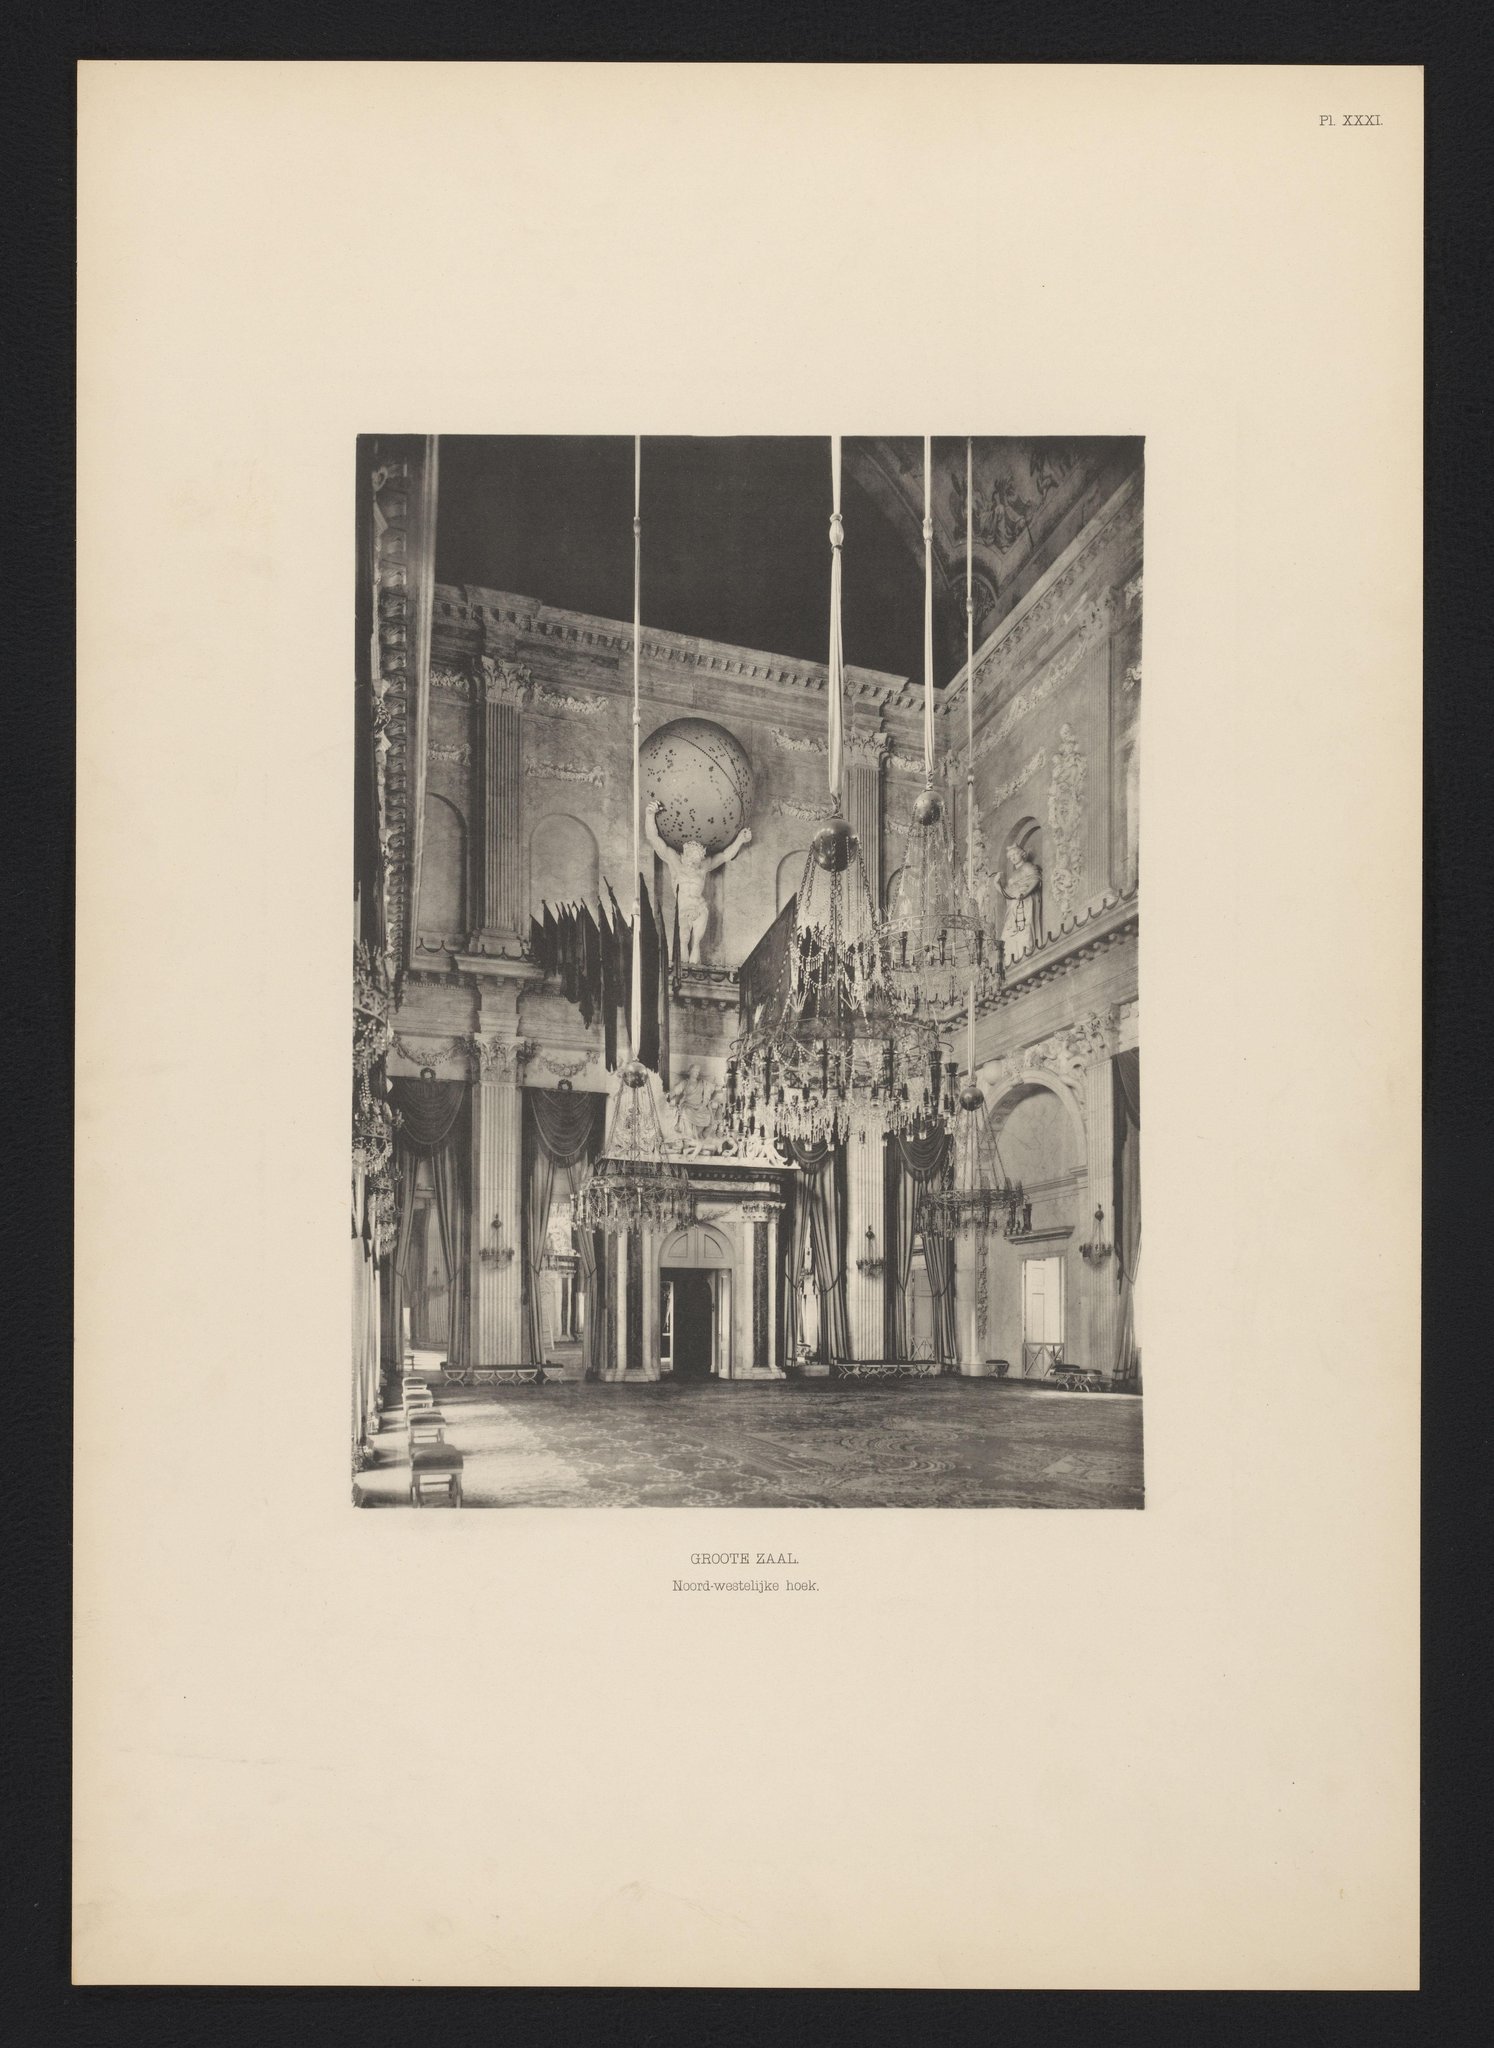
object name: fotomechanisch procedé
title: Burgerzaal, Paleis op de Dam, Amsterdam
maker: Anonymous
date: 1899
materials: cardboard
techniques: photograph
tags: palace, interior of the house, royal palace of amsterdam